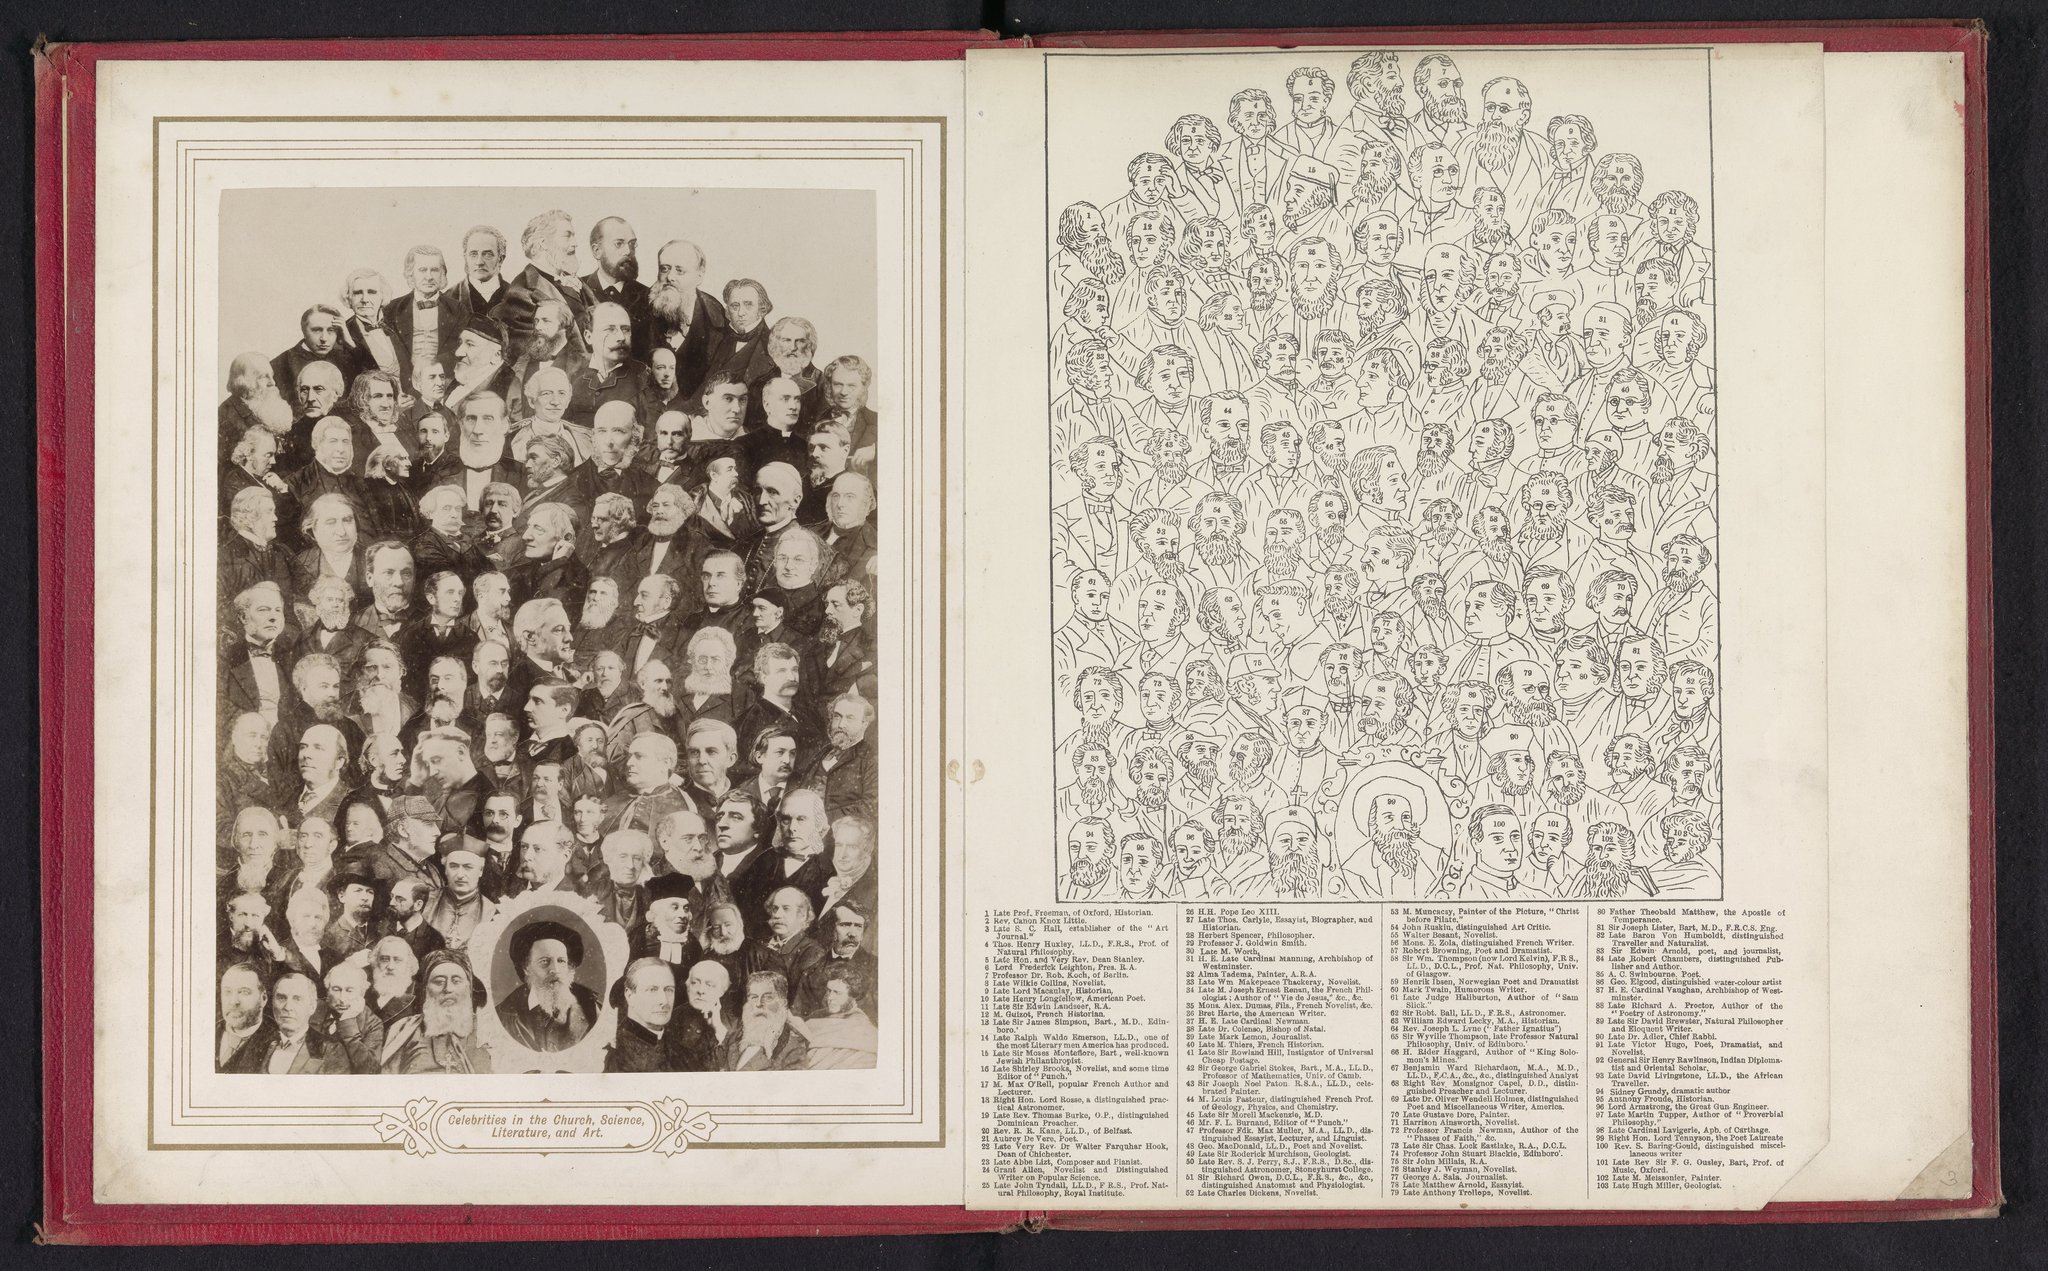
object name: photograph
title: Celebrities in the Church, Science, Literature, and Art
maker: Anonymous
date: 1873-1883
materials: photographic support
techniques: albumen print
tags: historical person (with name) - historical person (with name) portrayed in a group, in a group-portrait, historical persons